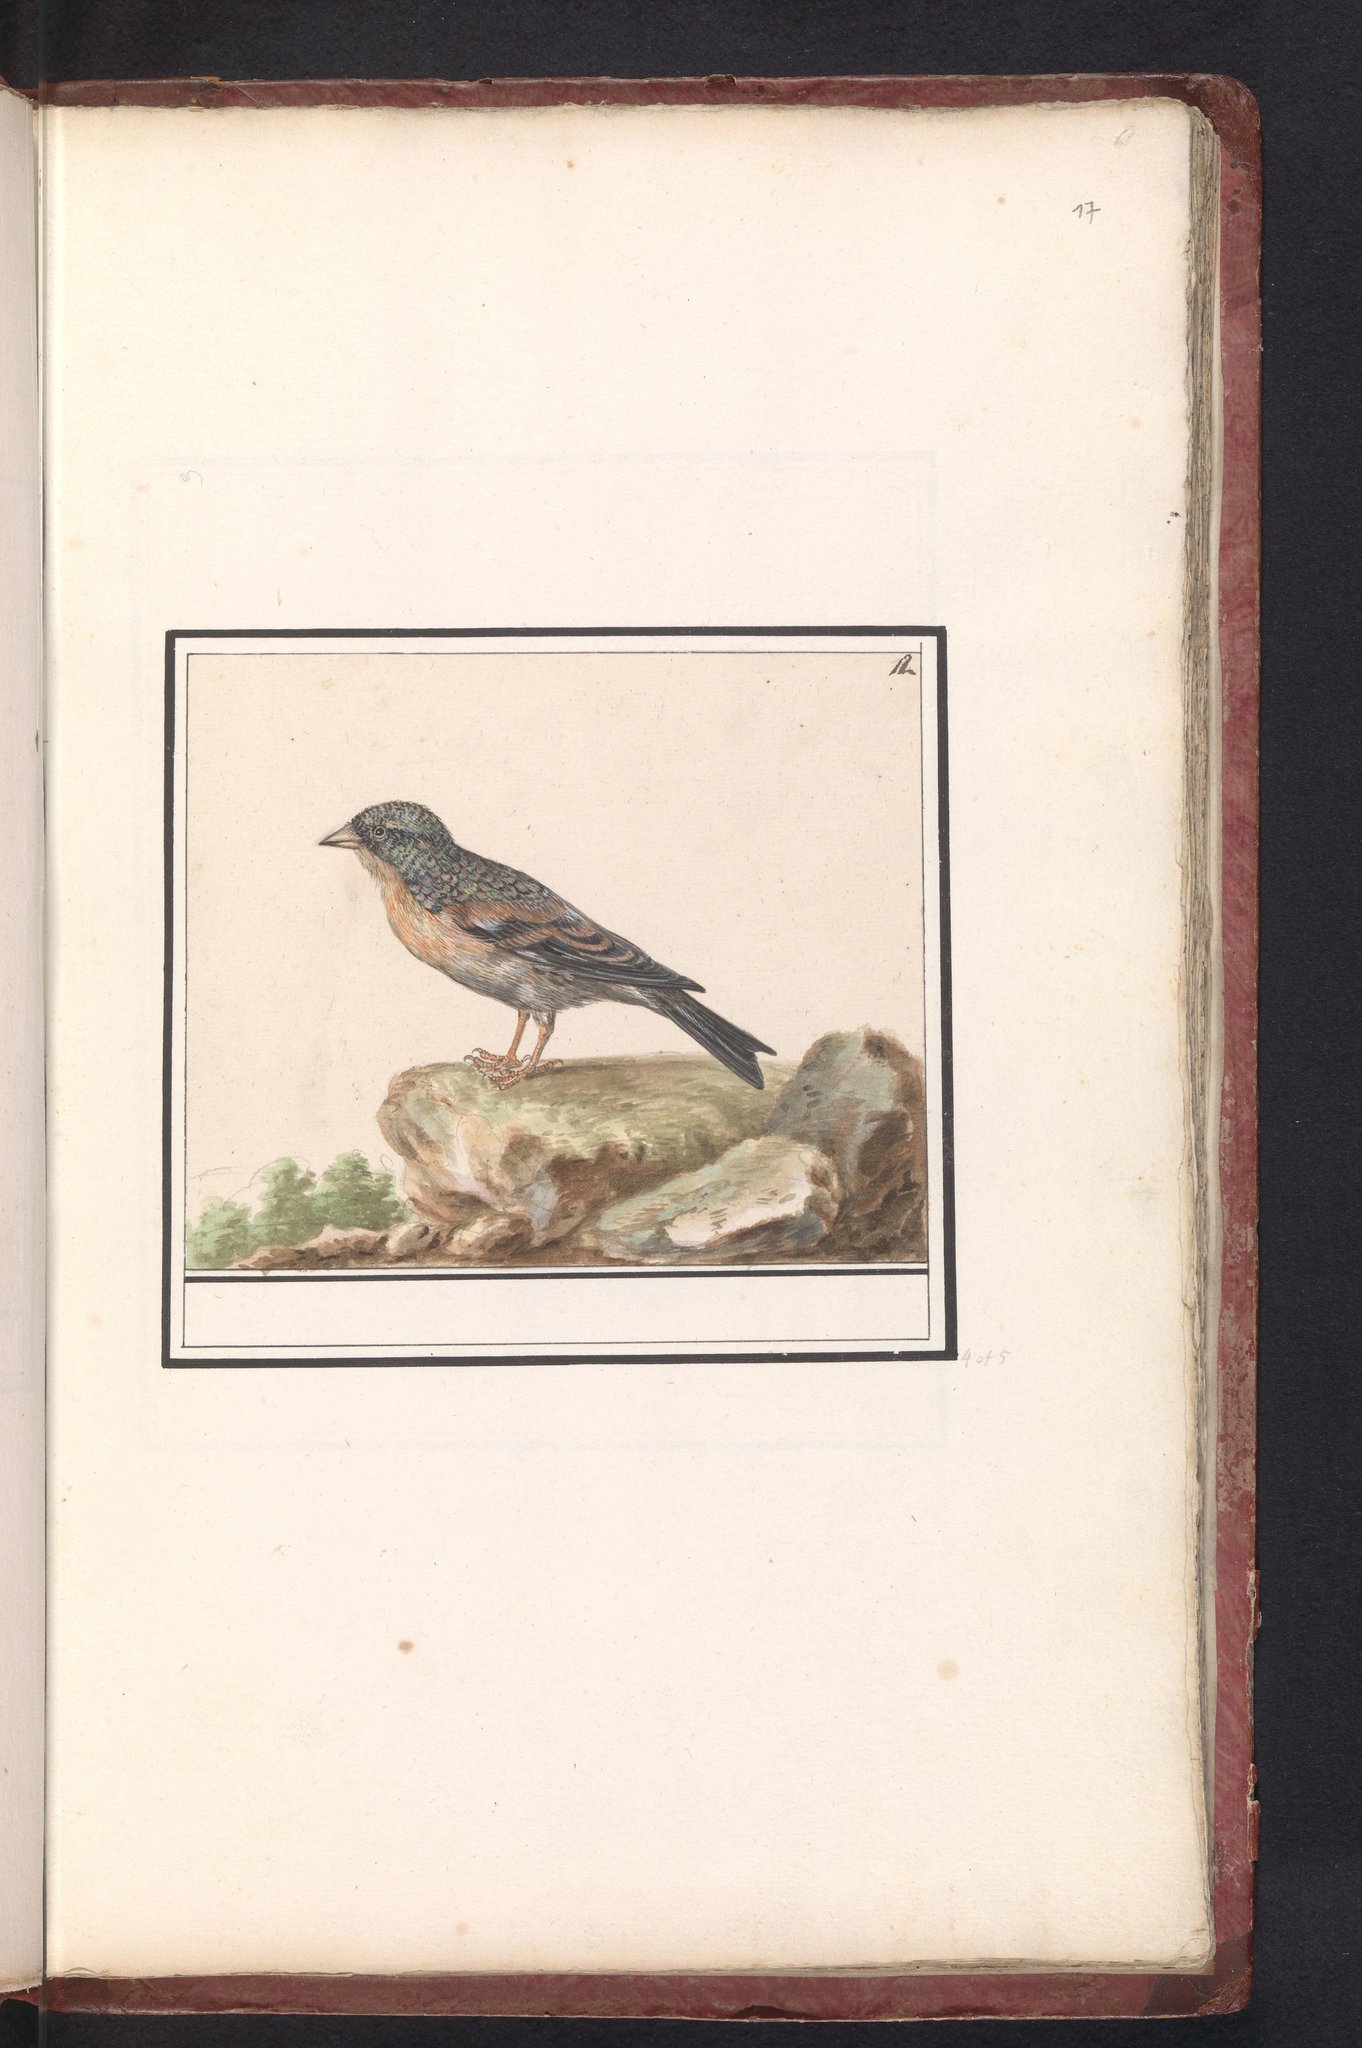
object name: drawing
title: Vink (Fringilla)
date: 1596-1610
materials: paint, paper, pencil, watercolor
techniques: brush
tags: song-birds: brambling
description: Onbekende vogel, waarschijnlijk een soort vink. Genummerd rechtsboven: 12. Onderdeel van het tweede album met tekeningen van vogels. Vierde van twaalf albums met tekeningen van dieren, vogels en planten bekend rond 1600, gemaakt in opdracht van keizer Rudolf II. Met toelichting in Nederlands, Latijn en Frans.